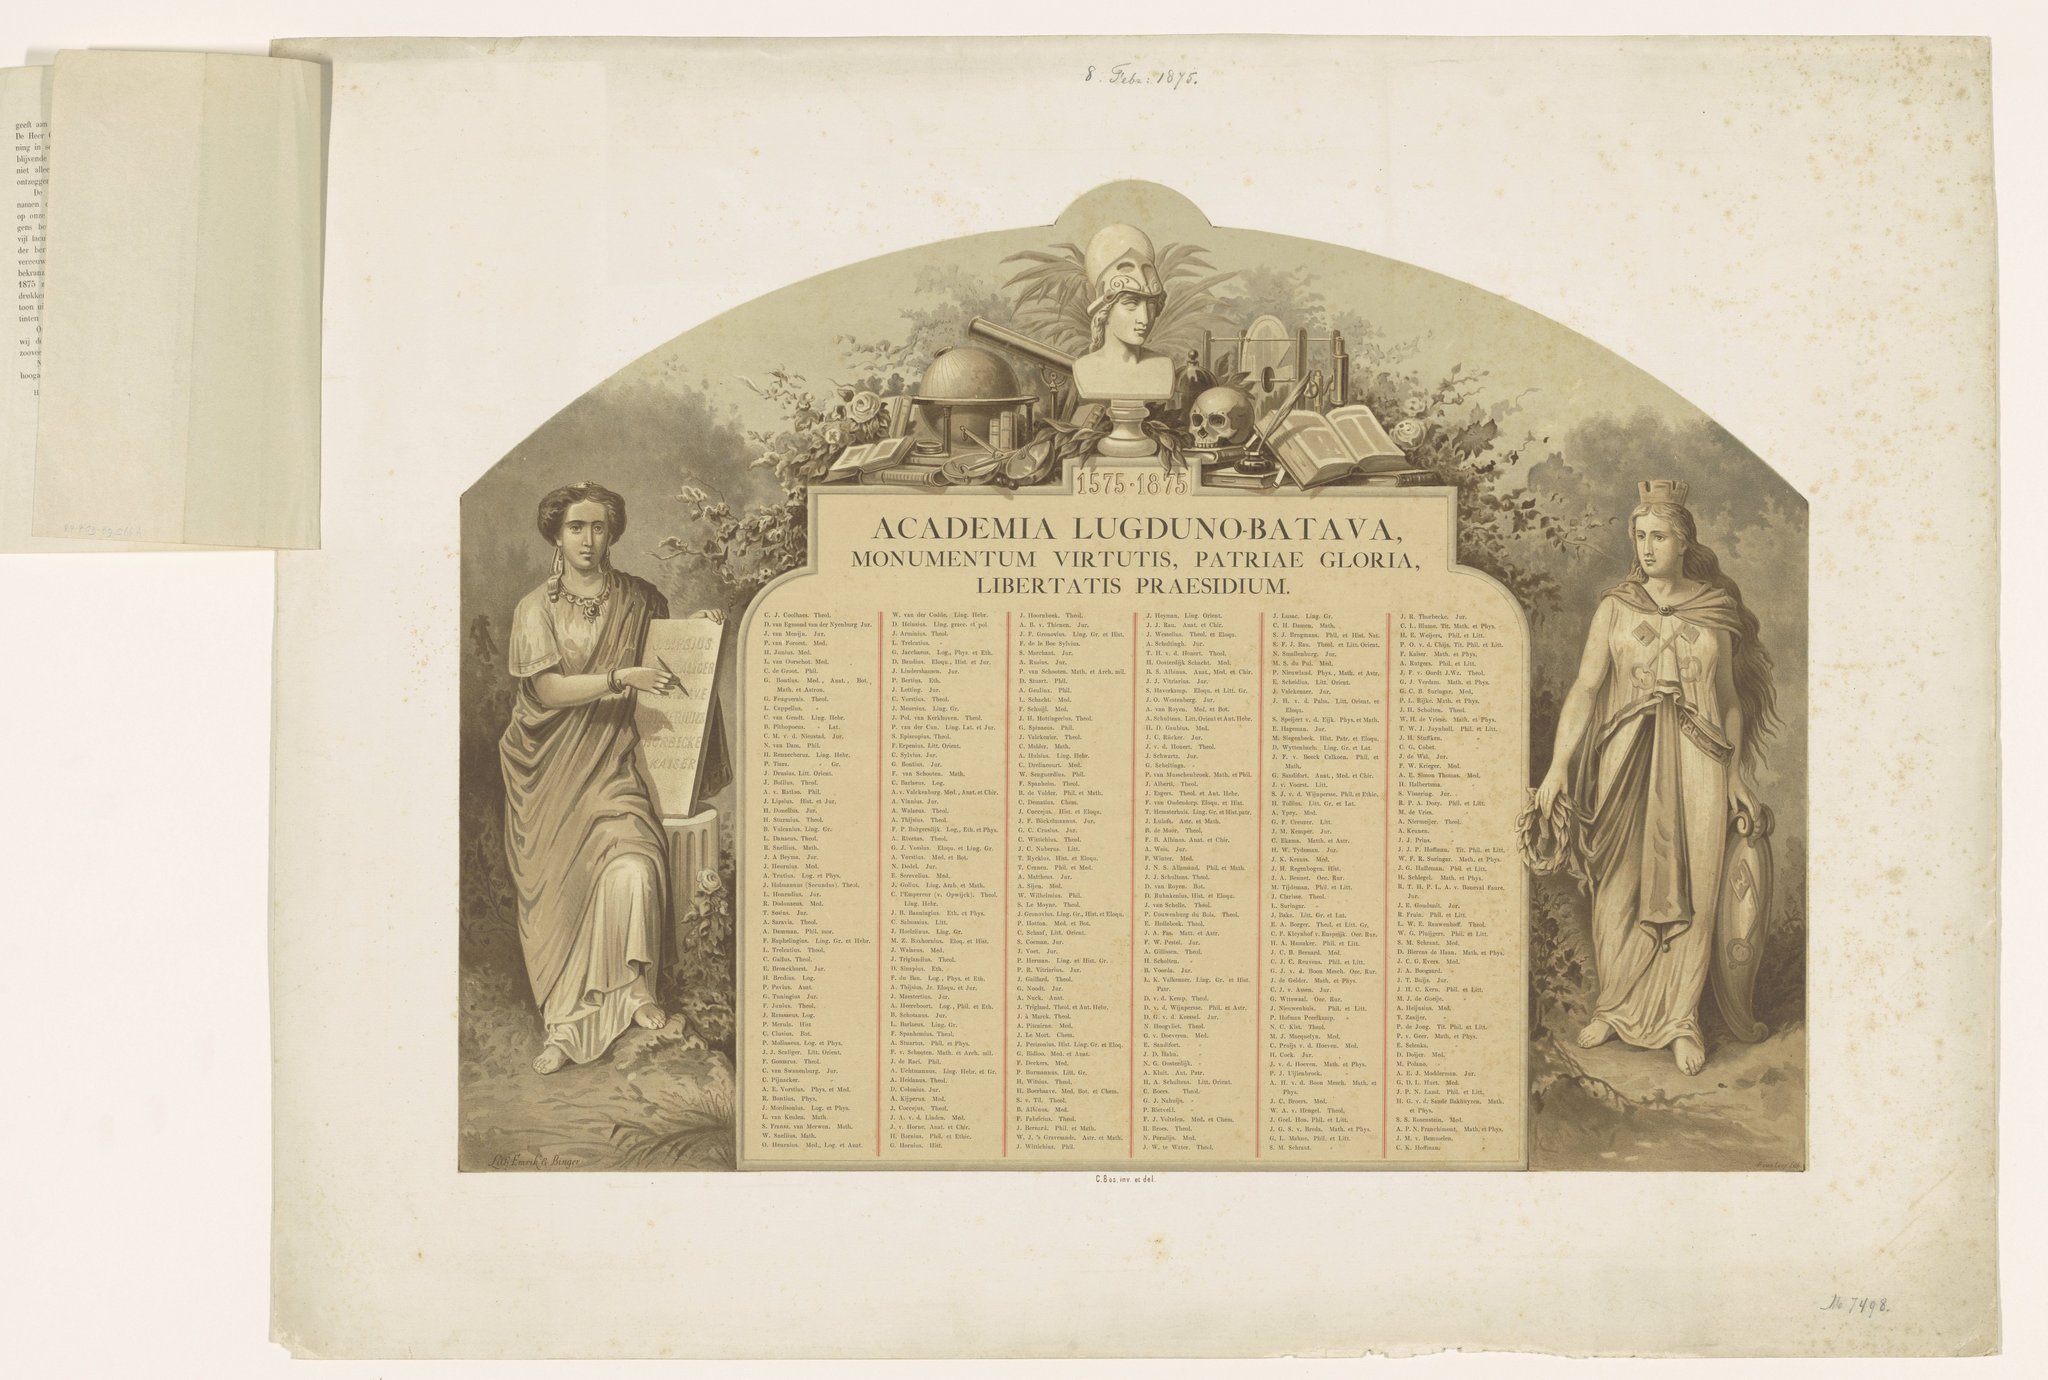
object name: print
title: Gedenkplaat bij het 3e eeuwfeest van de Leidse Hogeschool, 1575-1875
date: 1875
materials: paper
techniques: tone lithography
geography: haarlem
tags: personification of a city, town-patron(ess), 'historia'; 'historia' (ripa), commemoration of the founding of a university, leiden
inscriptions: collector's mark: Lugt 2228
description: Gedenkplaat bij het 3e eeuwfeest van de Leidse Hogeschool, 8 februari 1575-1875. Centraal een lijst van alle hoogleraren sinds de oprichting. Links de Geschiedenis, rechts de stedenmaagd van Leiden. Bovenaan attributen van de vijf faculteiten. Bij de prent behoort een intekenbiljet (dat op de prent is geplakt).